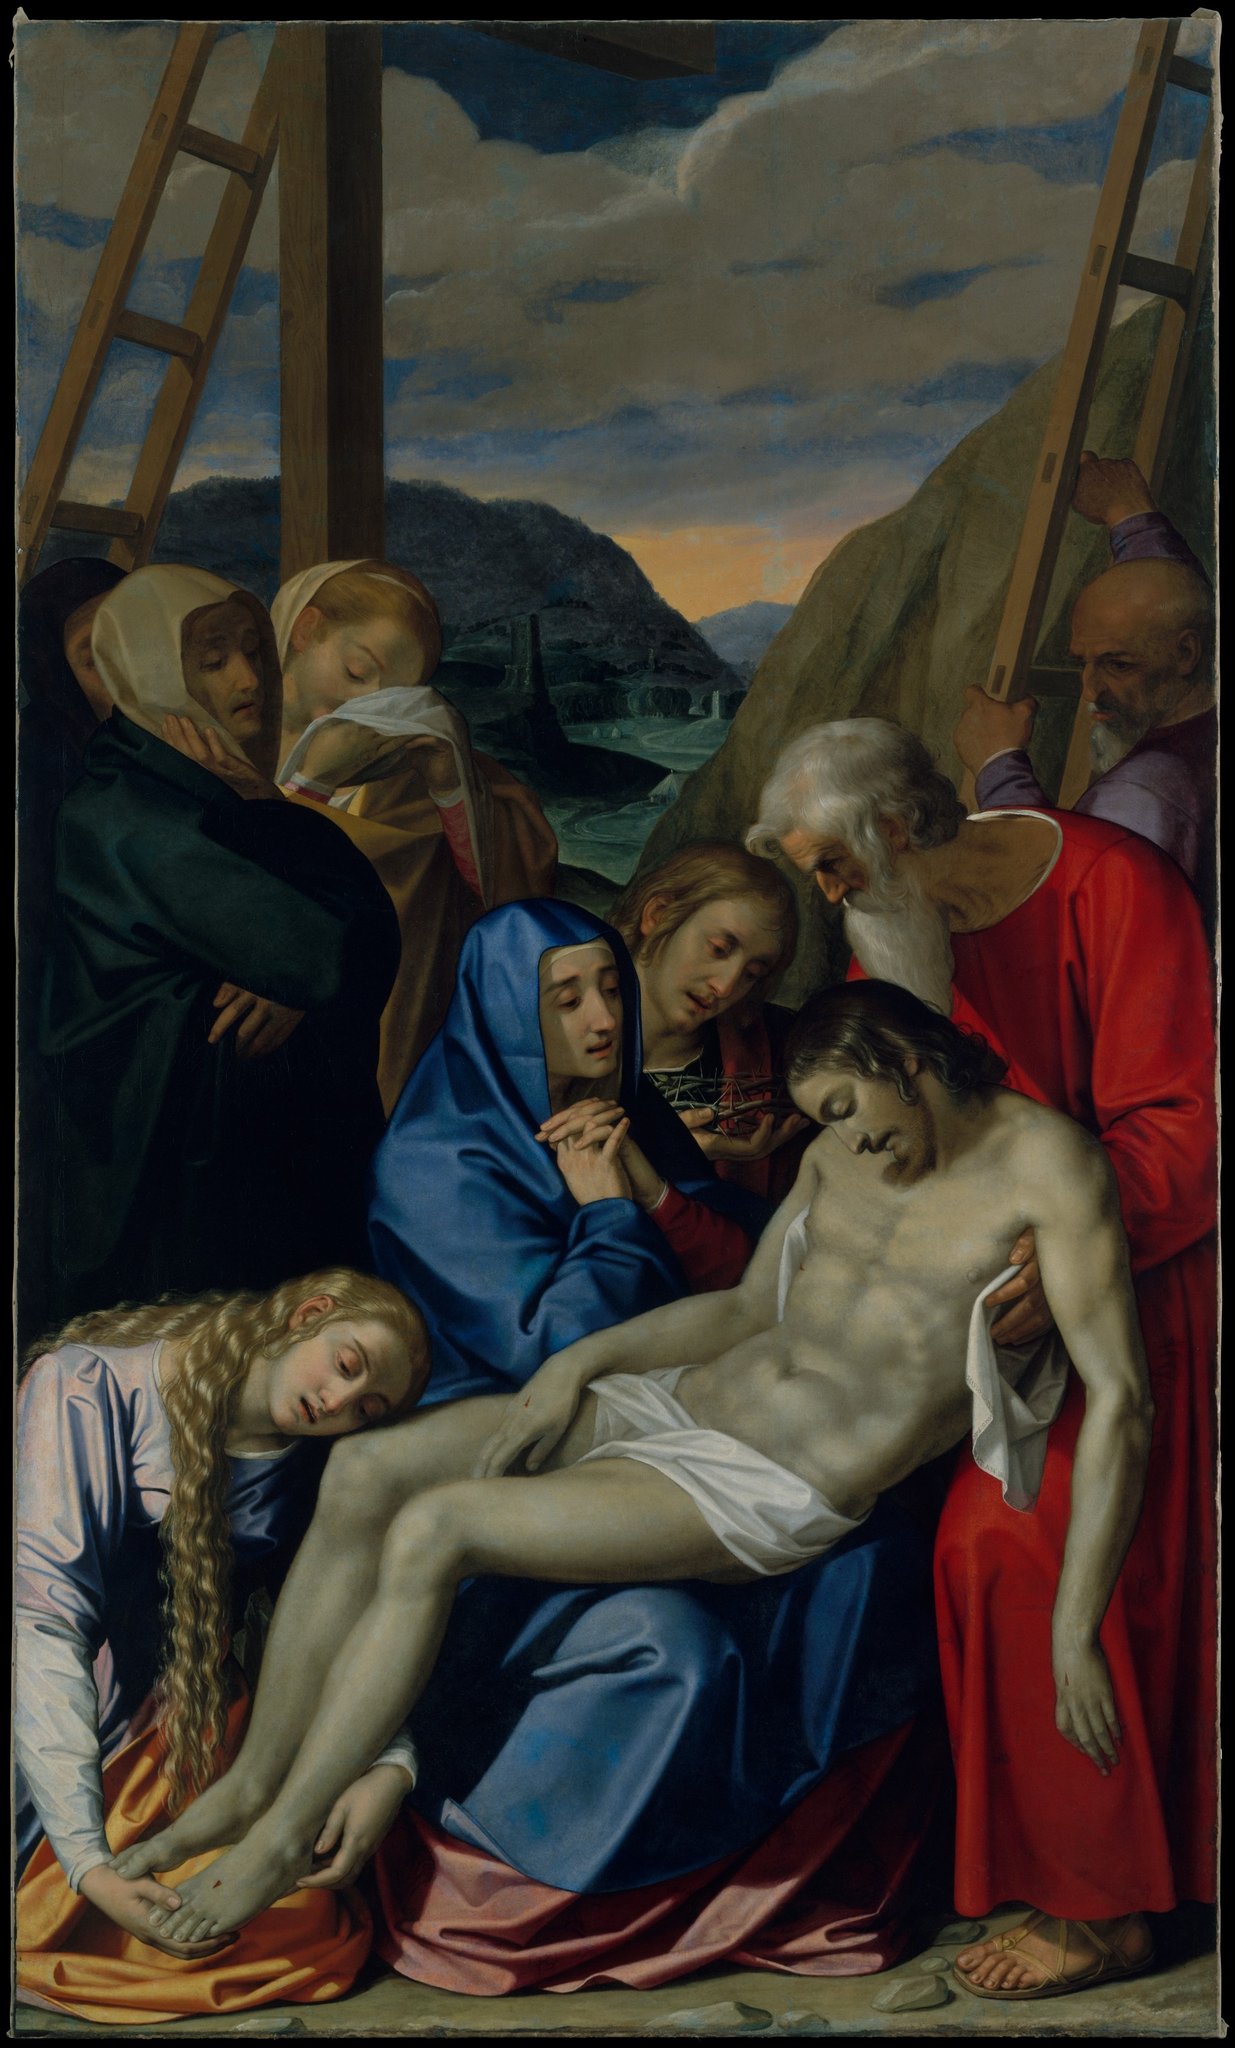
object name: painting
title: The Lamentation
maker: scipione pulzone (il gaetano)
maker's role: artist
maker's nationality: italian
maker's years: 1569-1598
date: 1593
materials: canvas, oil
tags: sadness,suffering,christ,mary magdalene,saint john the evangelist,virgin mary,lamentation,death